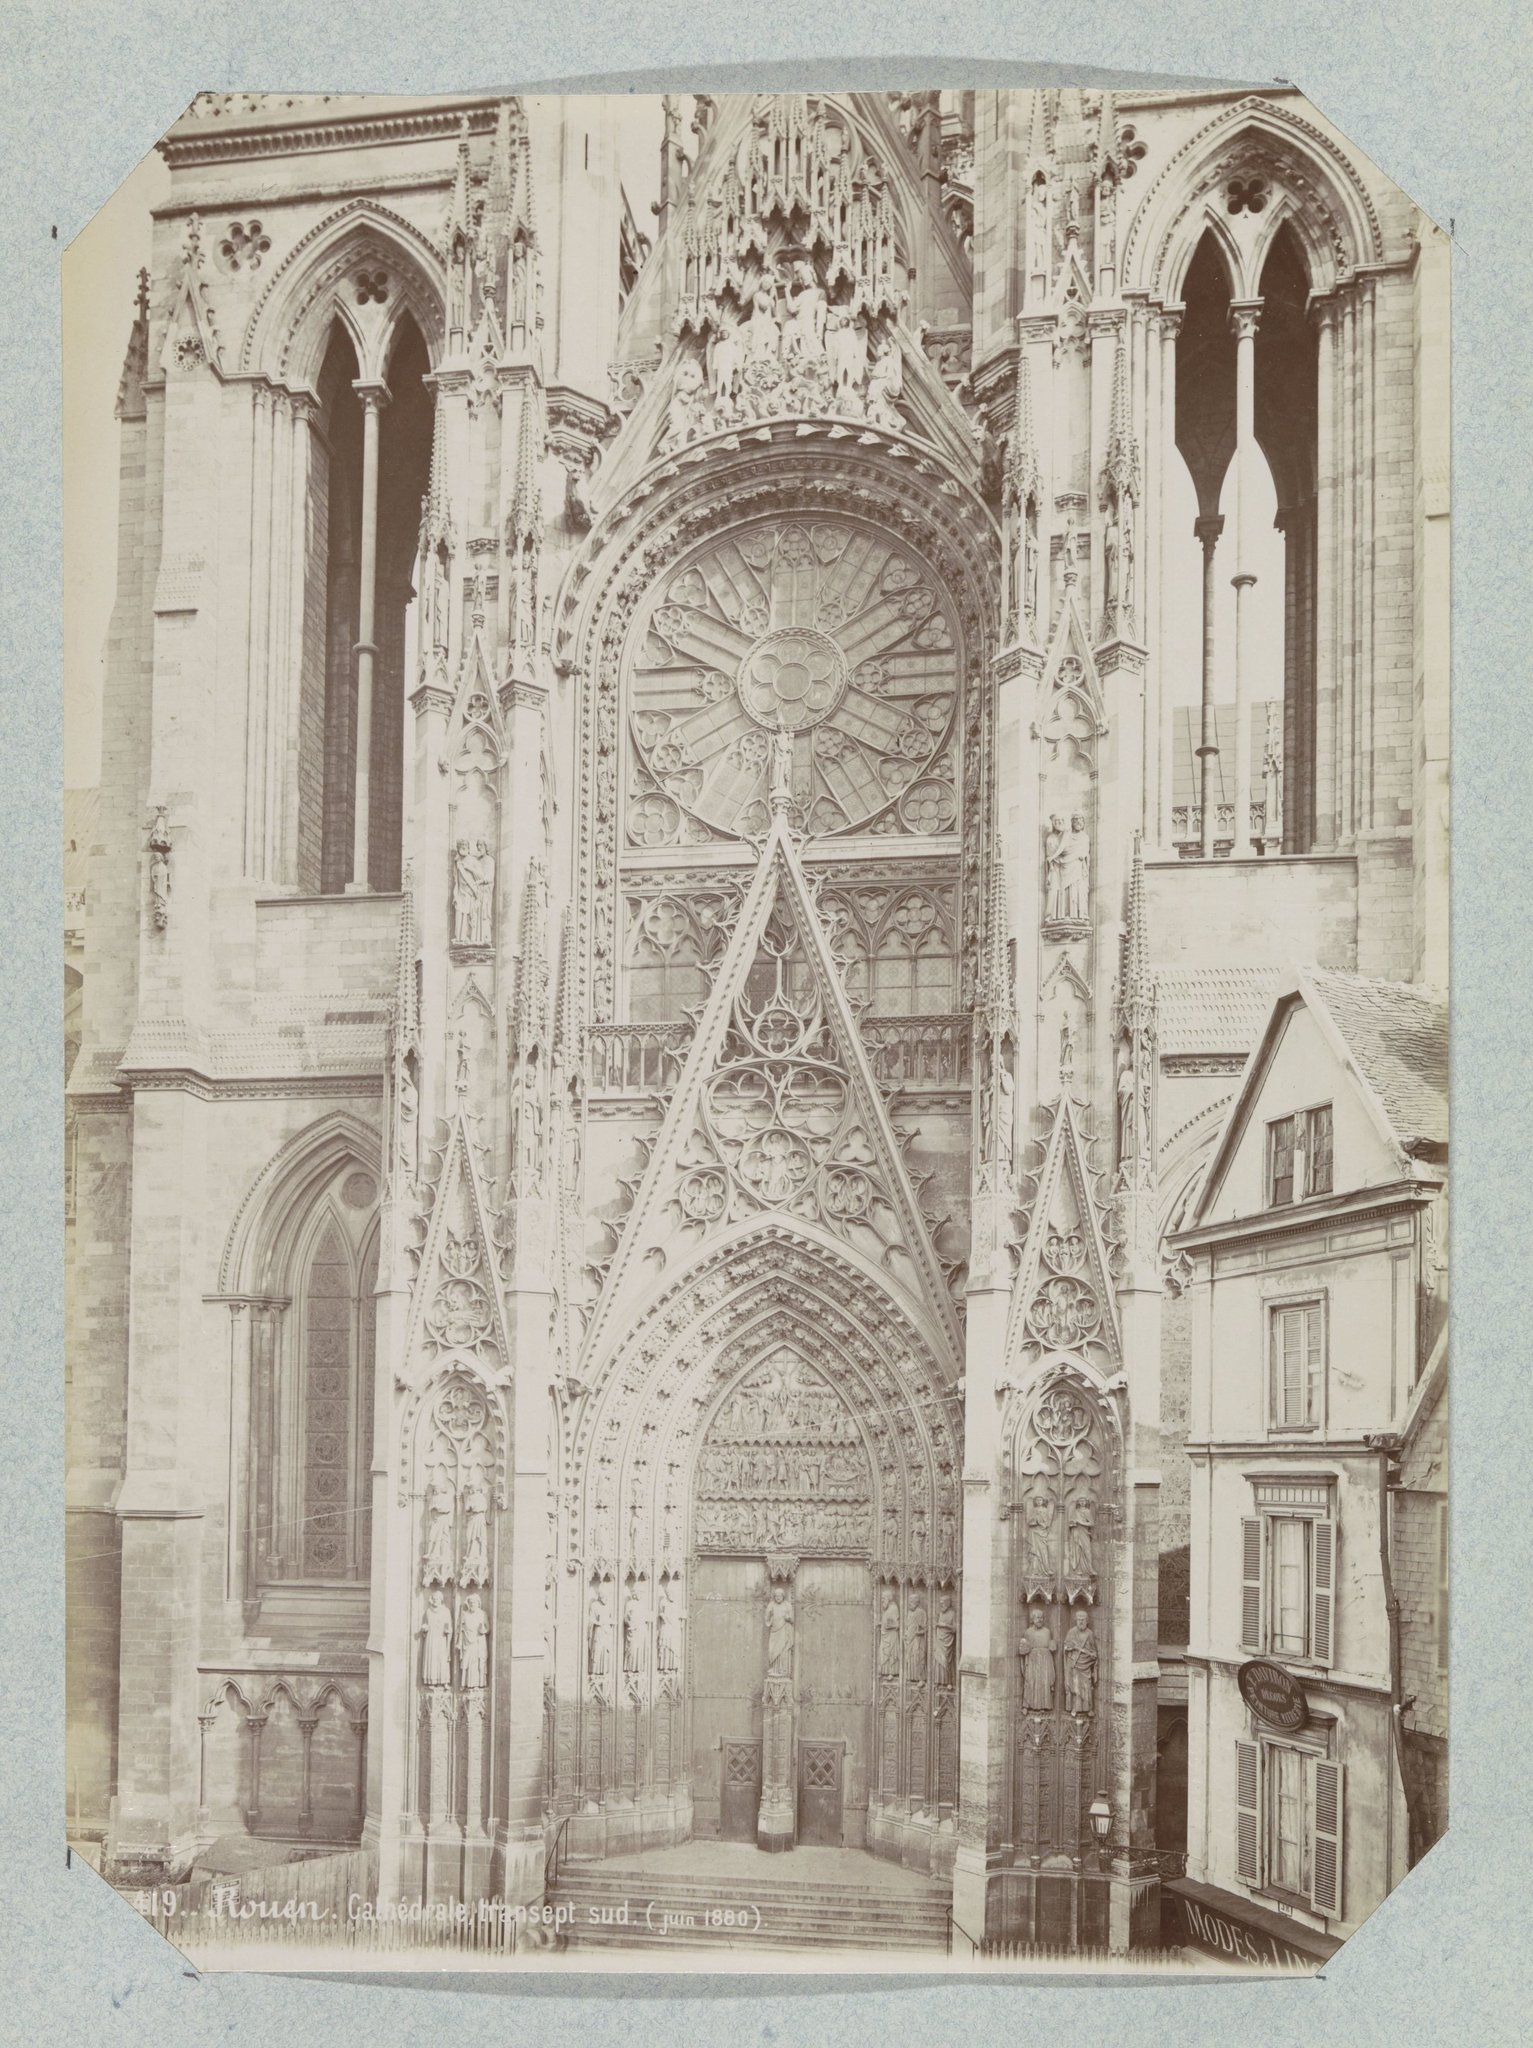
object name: photograph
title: Zuidtransept van de kathedraal van Rouen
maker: paul robert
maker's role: fotograaf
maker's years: 1865-1905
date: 1806-1880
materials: photographic support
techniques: albumen print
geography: rouen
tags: parts of church exterior and annexes: portal, parts of church exterior and annexes: transept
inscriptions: number: ‘419’, name: ‘[...] Robert Paris’, inscription: ‘Monuments Historiques’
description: Onderdeel van Fotoalbum met opnames van monumenten in Frankrijk.